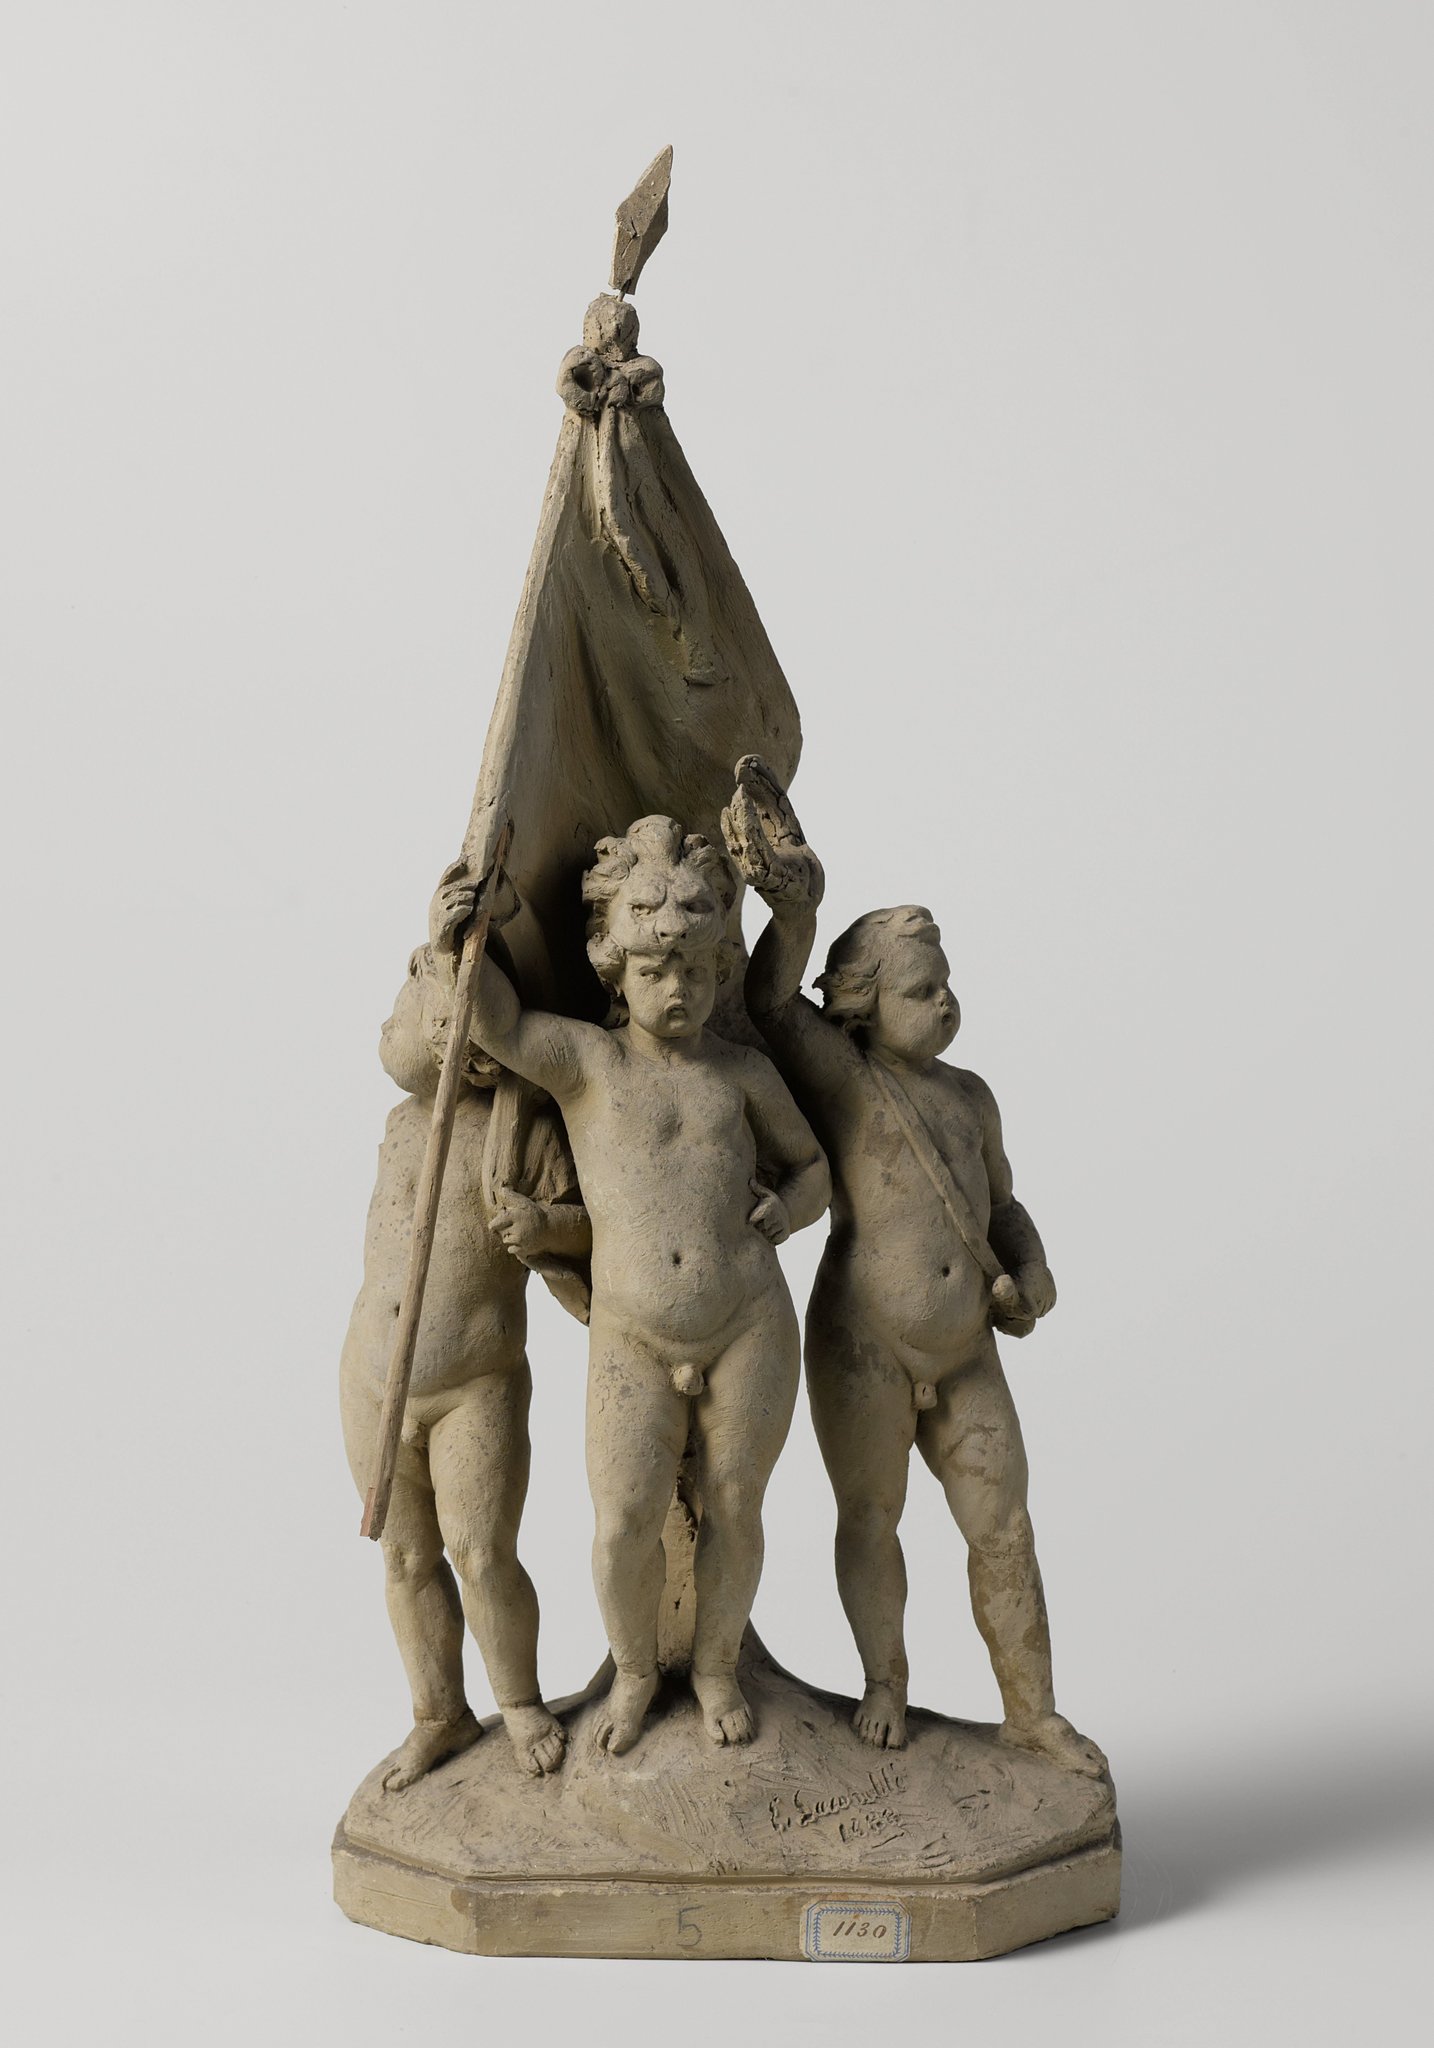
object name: sculpture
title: Overwinning van de vlag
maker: eugène lacomblé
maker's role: draughtsman, painter, sculptor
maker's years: 1828-1905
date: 1888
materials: clay